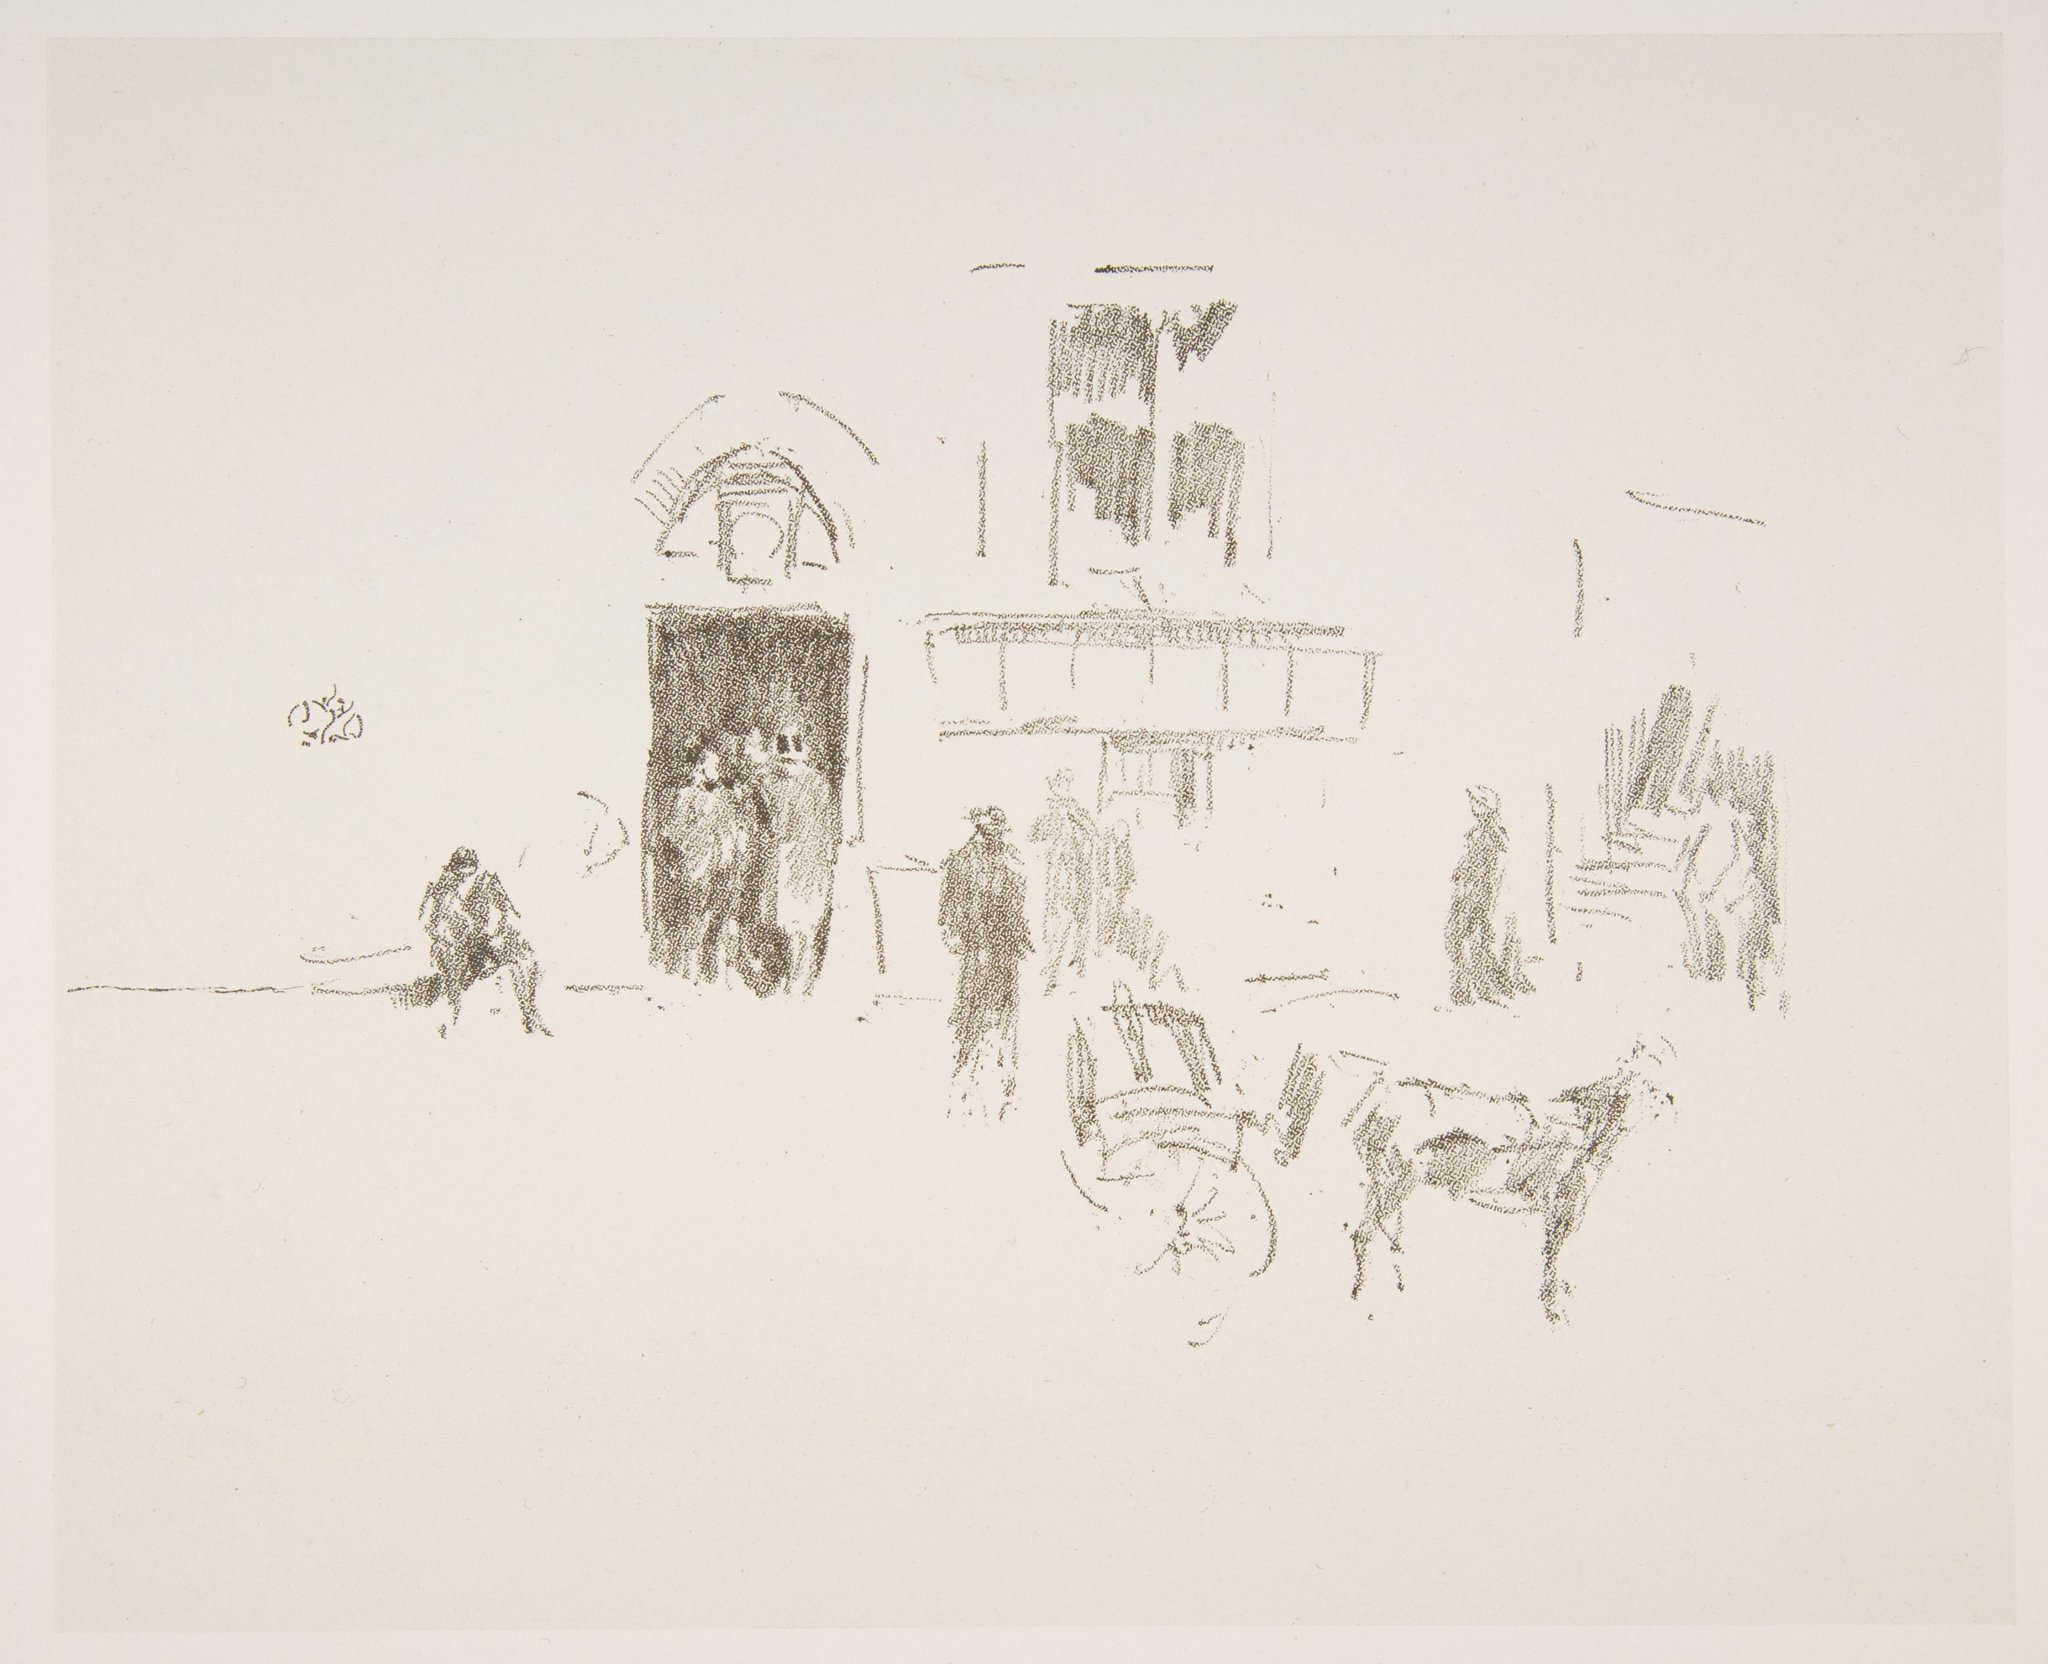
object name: print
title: Gaiety Stage Door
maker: james mcneill whistler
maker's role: artist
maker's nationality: american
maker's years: 1834-1903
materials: ink, paper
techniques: printing, scraping, lithography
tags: doors,men,women